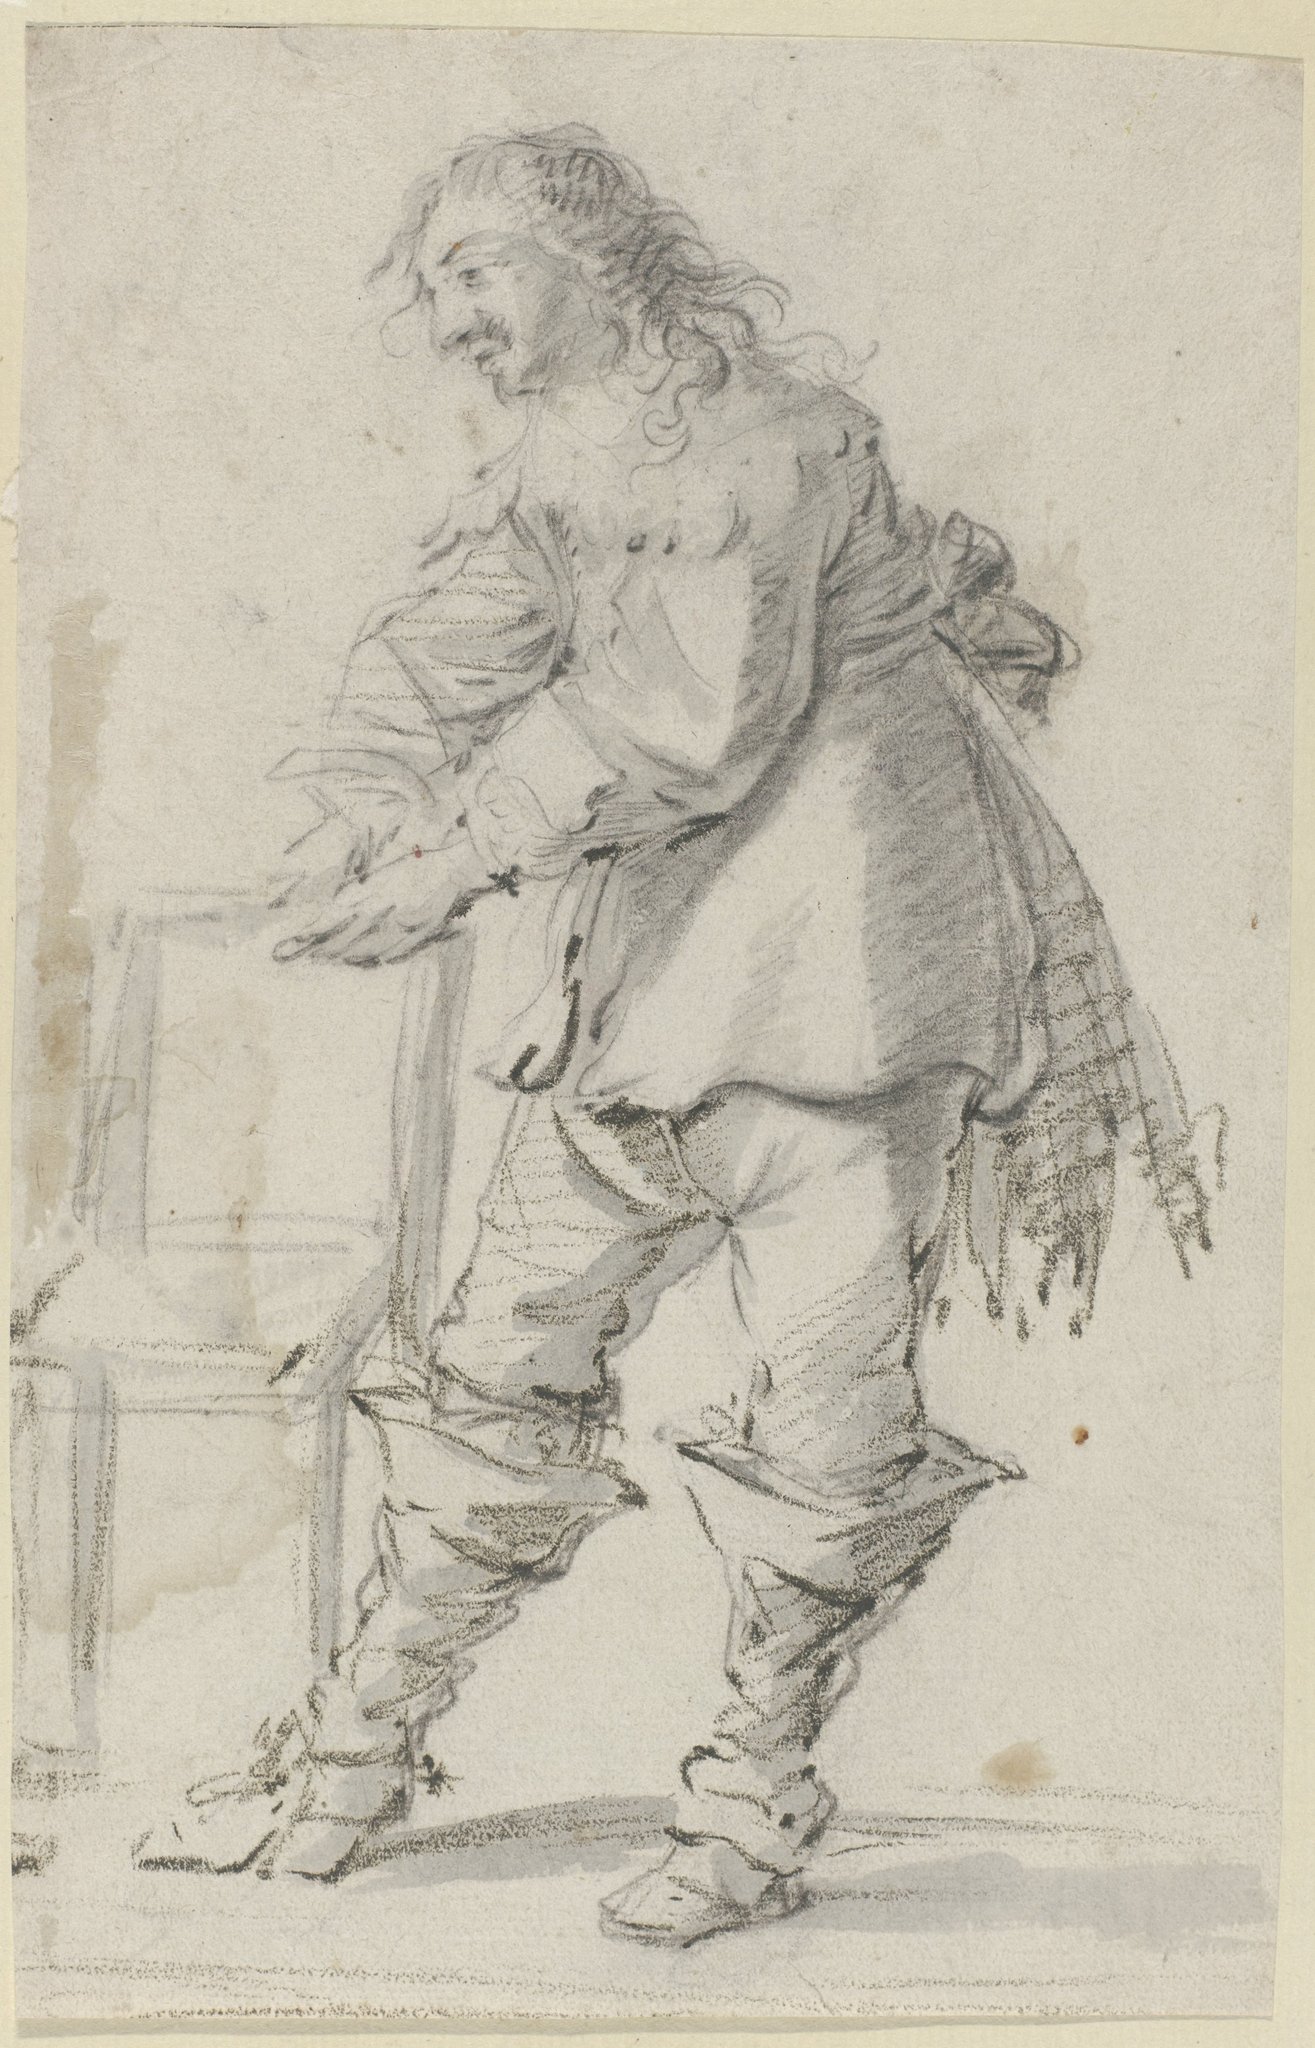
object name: drawing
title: Staande ruiter bij stoel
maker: Anonymous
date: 1600-1699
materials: chalk, charcoal, paper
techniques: brush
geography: netherlands